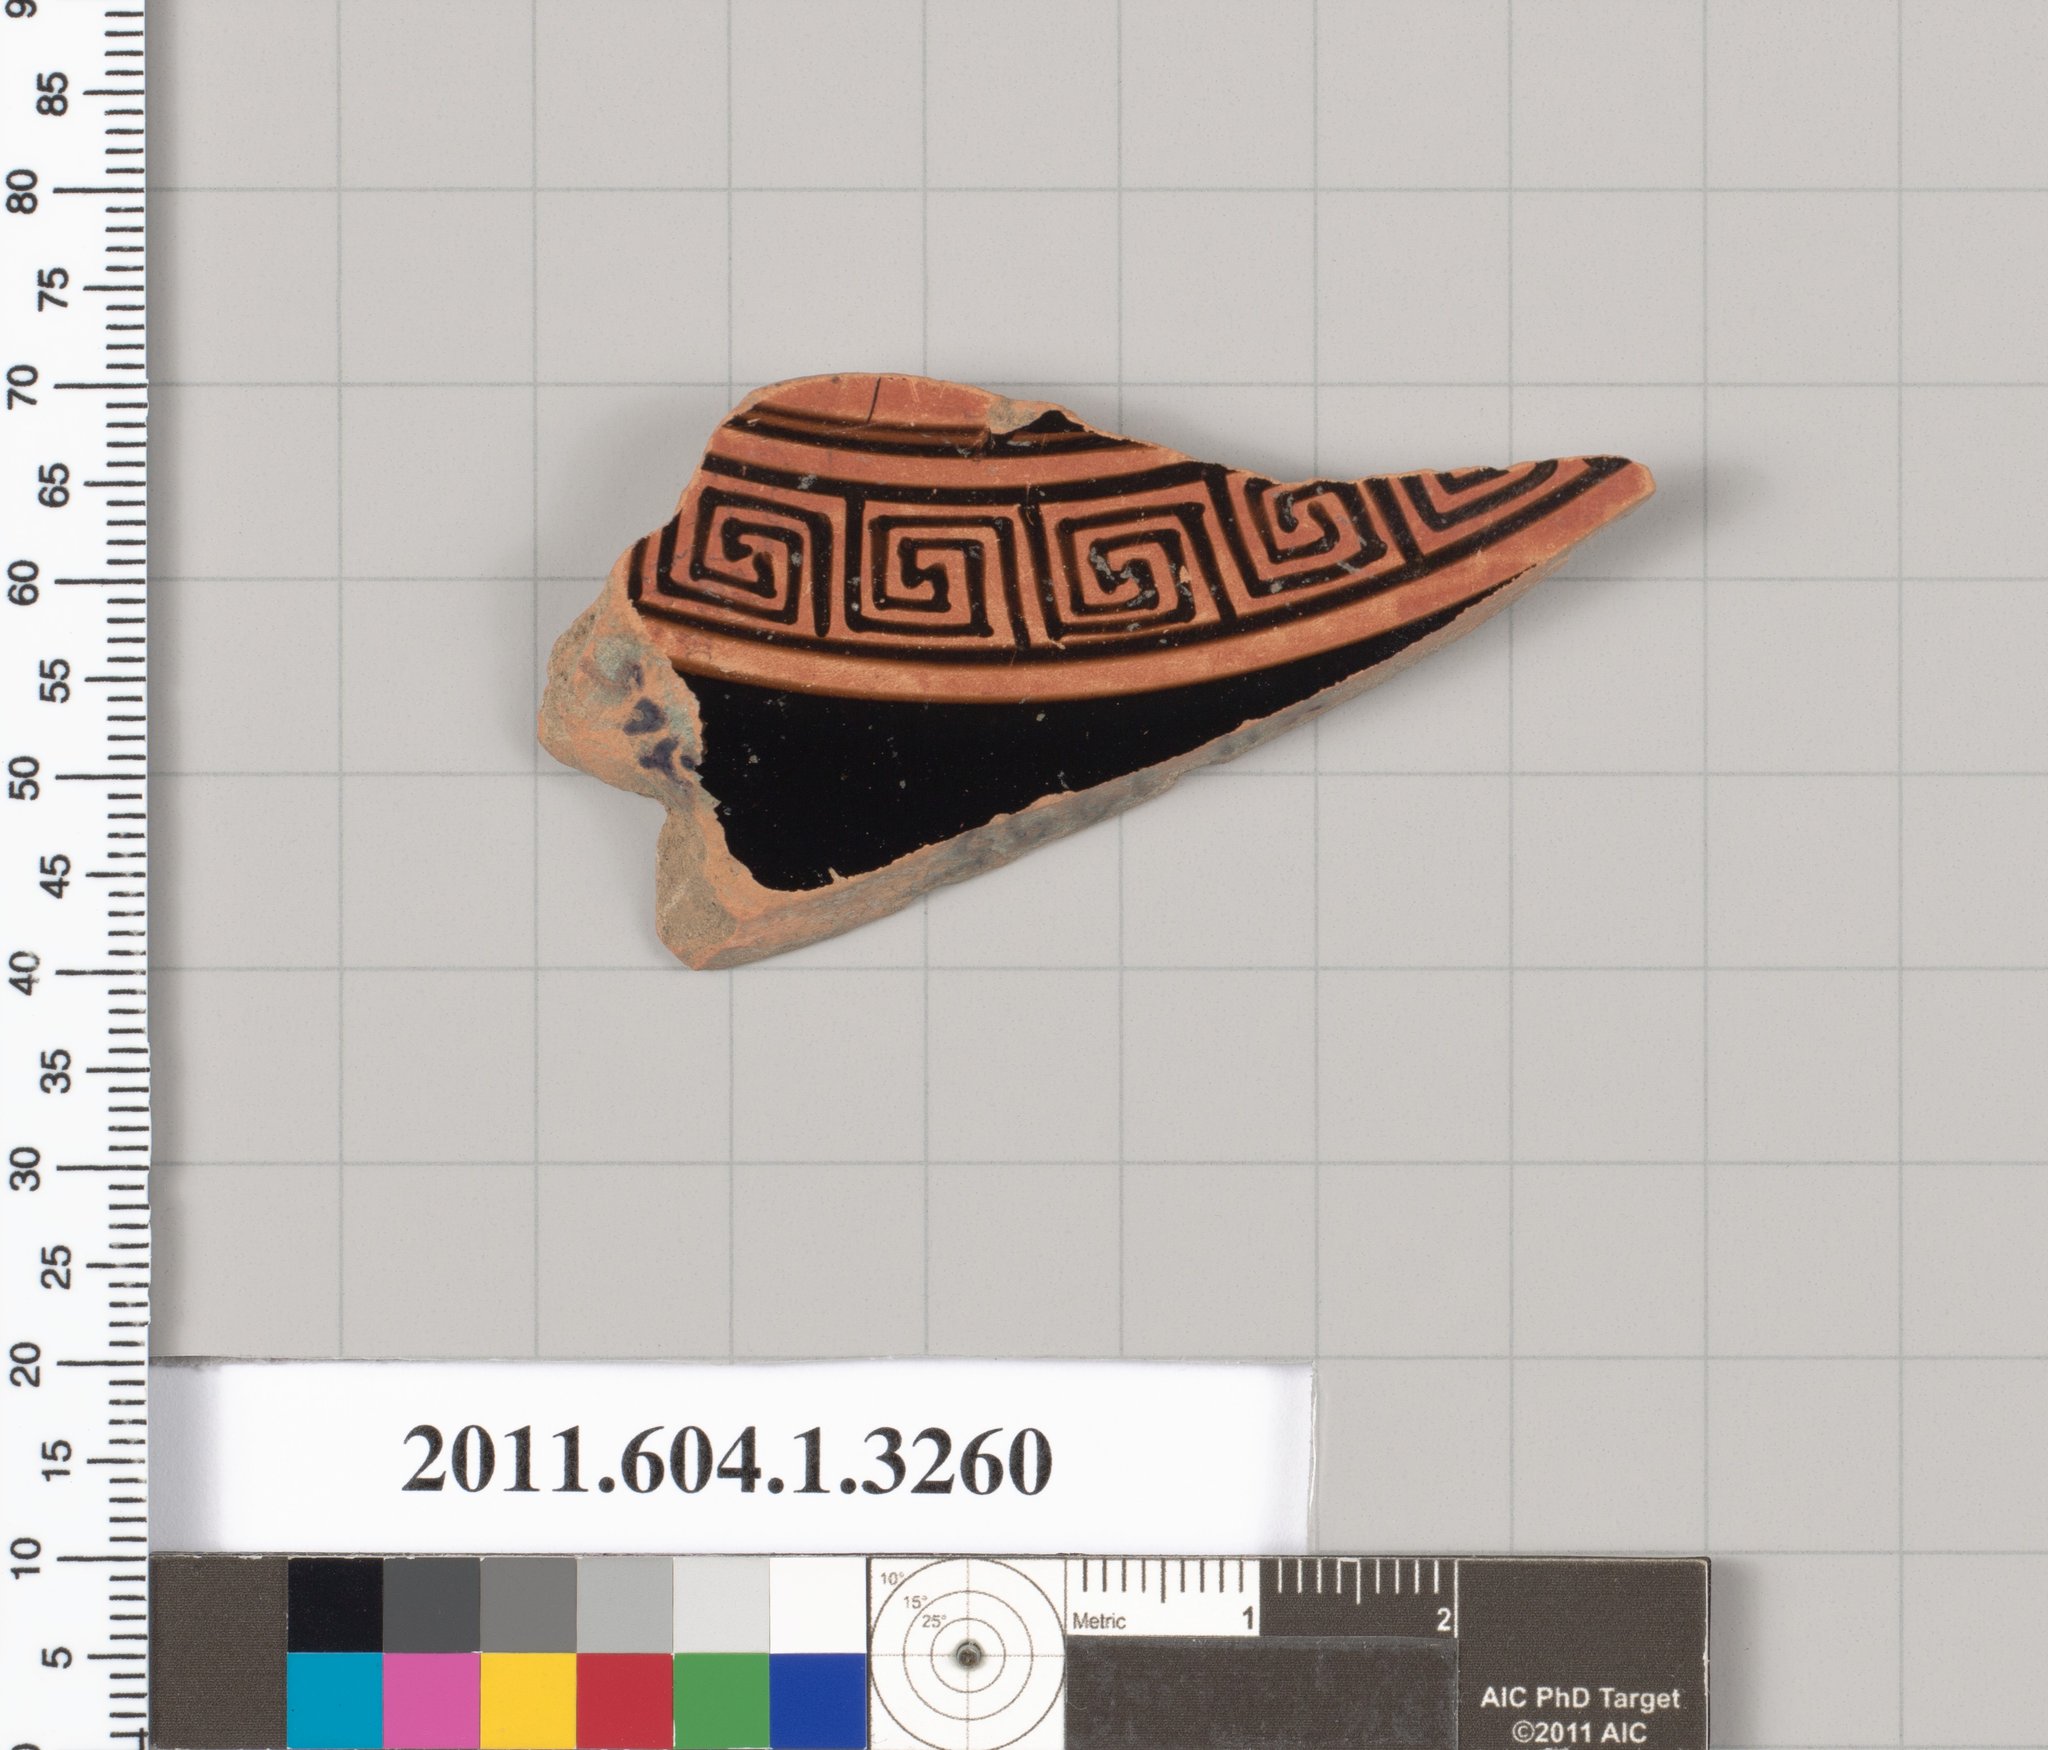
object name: kylix fragment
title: Terracotta fragment of a kylix (drinking cup)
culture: greek, attic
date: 490-480 BCE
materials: terracotta